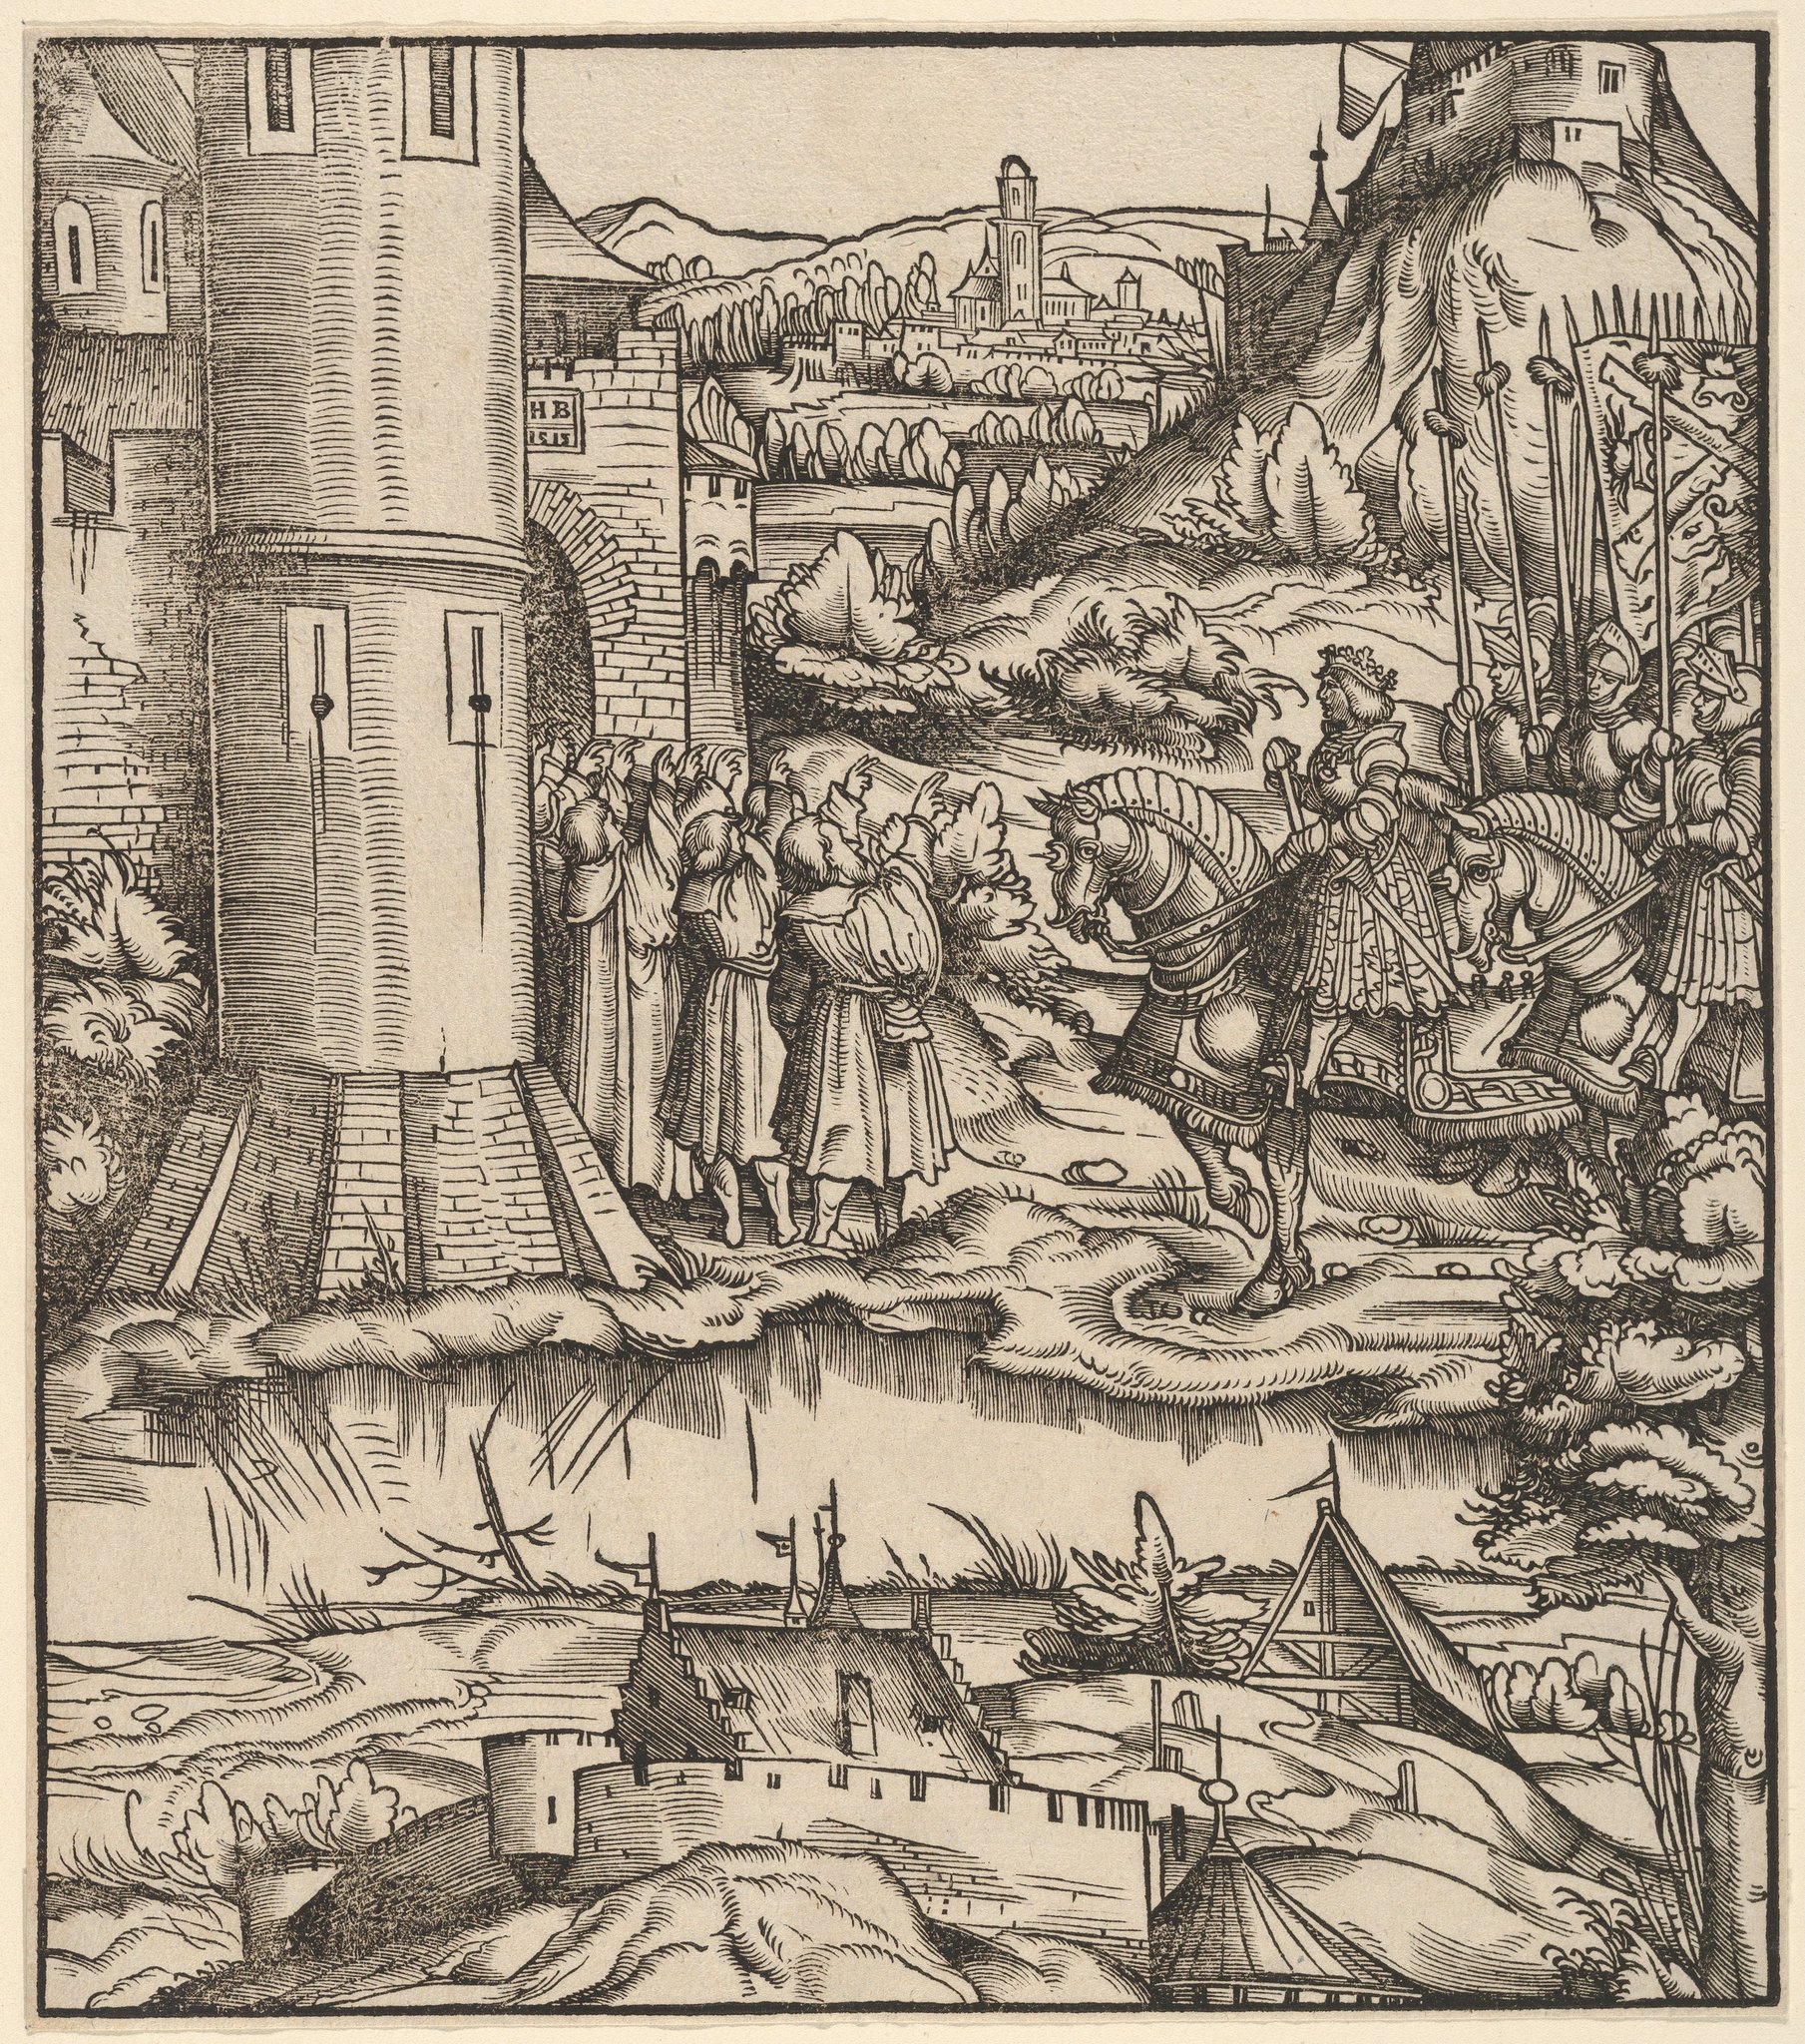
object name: print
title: The Surrender of the Venetian Townships, from "Der Weisskunig"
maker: hans burgkmair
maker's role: artist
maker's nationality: german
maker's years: 1473-1531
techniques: woodcut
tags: buildings,soldiers,men,horses,venice